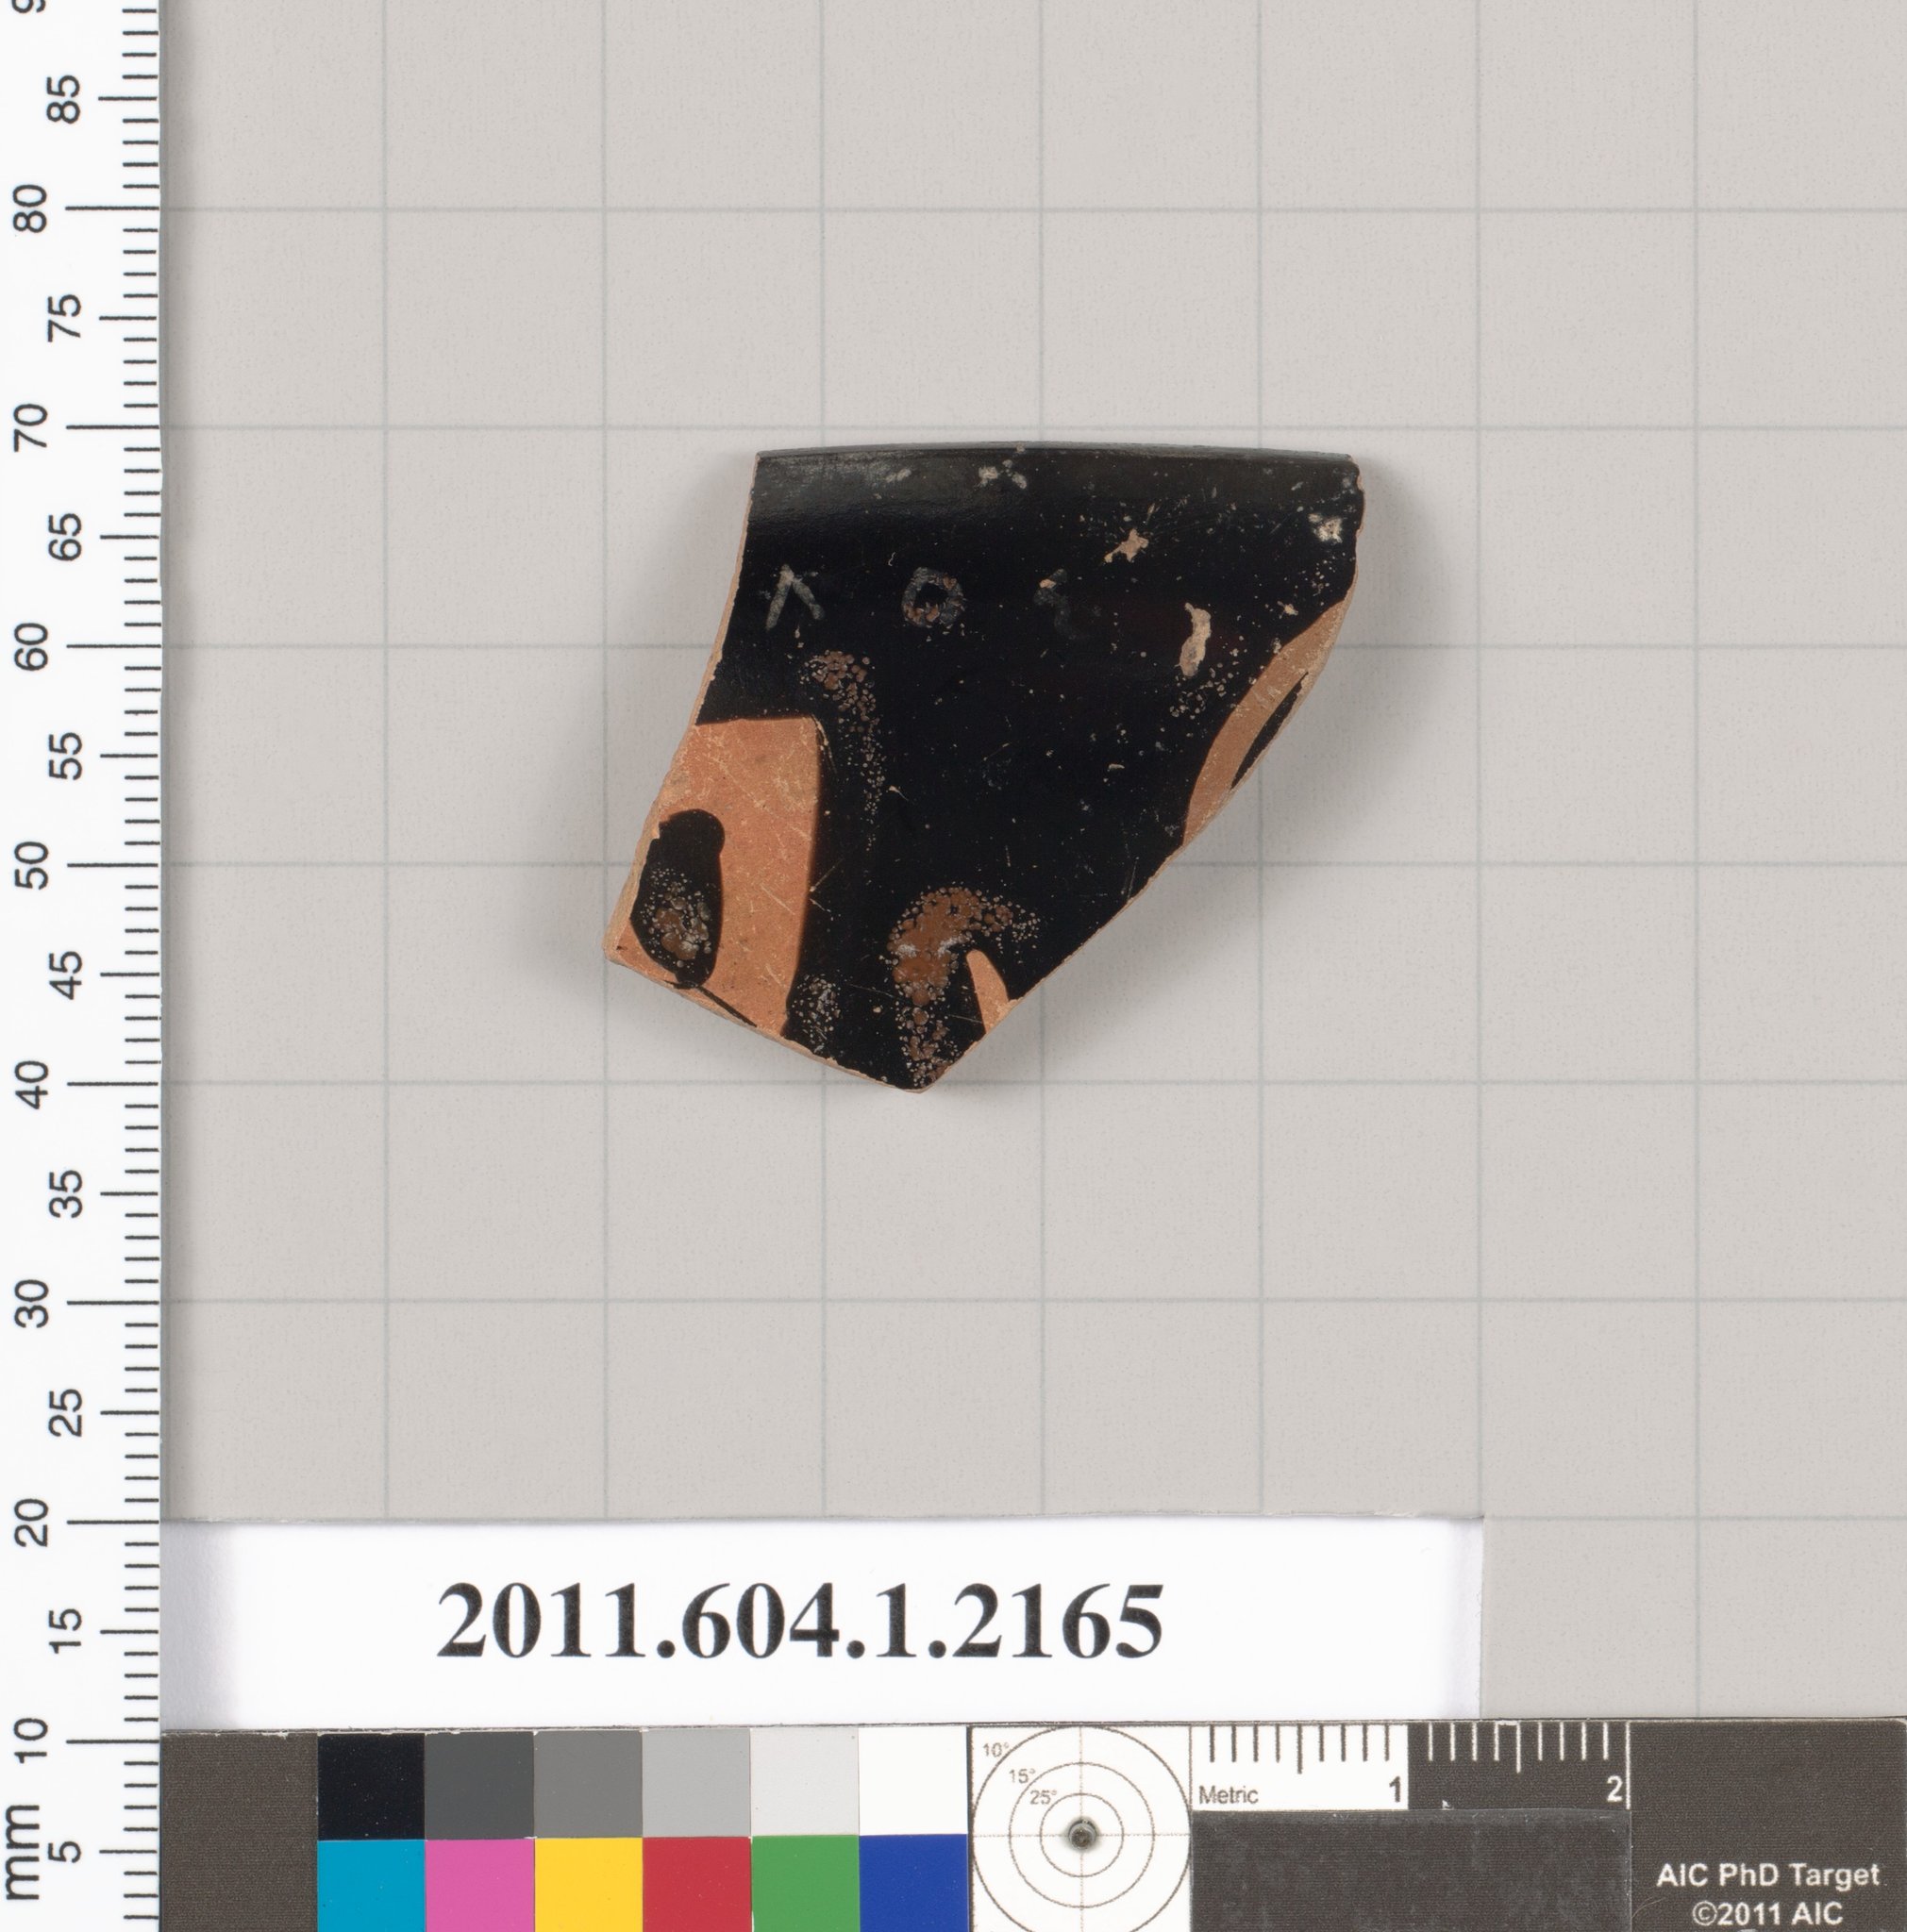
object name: kylix fragment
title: Terracotta rim fragment of a kylix (drinking cup)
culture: greek, attic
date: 500-451 BCE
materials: terracotta